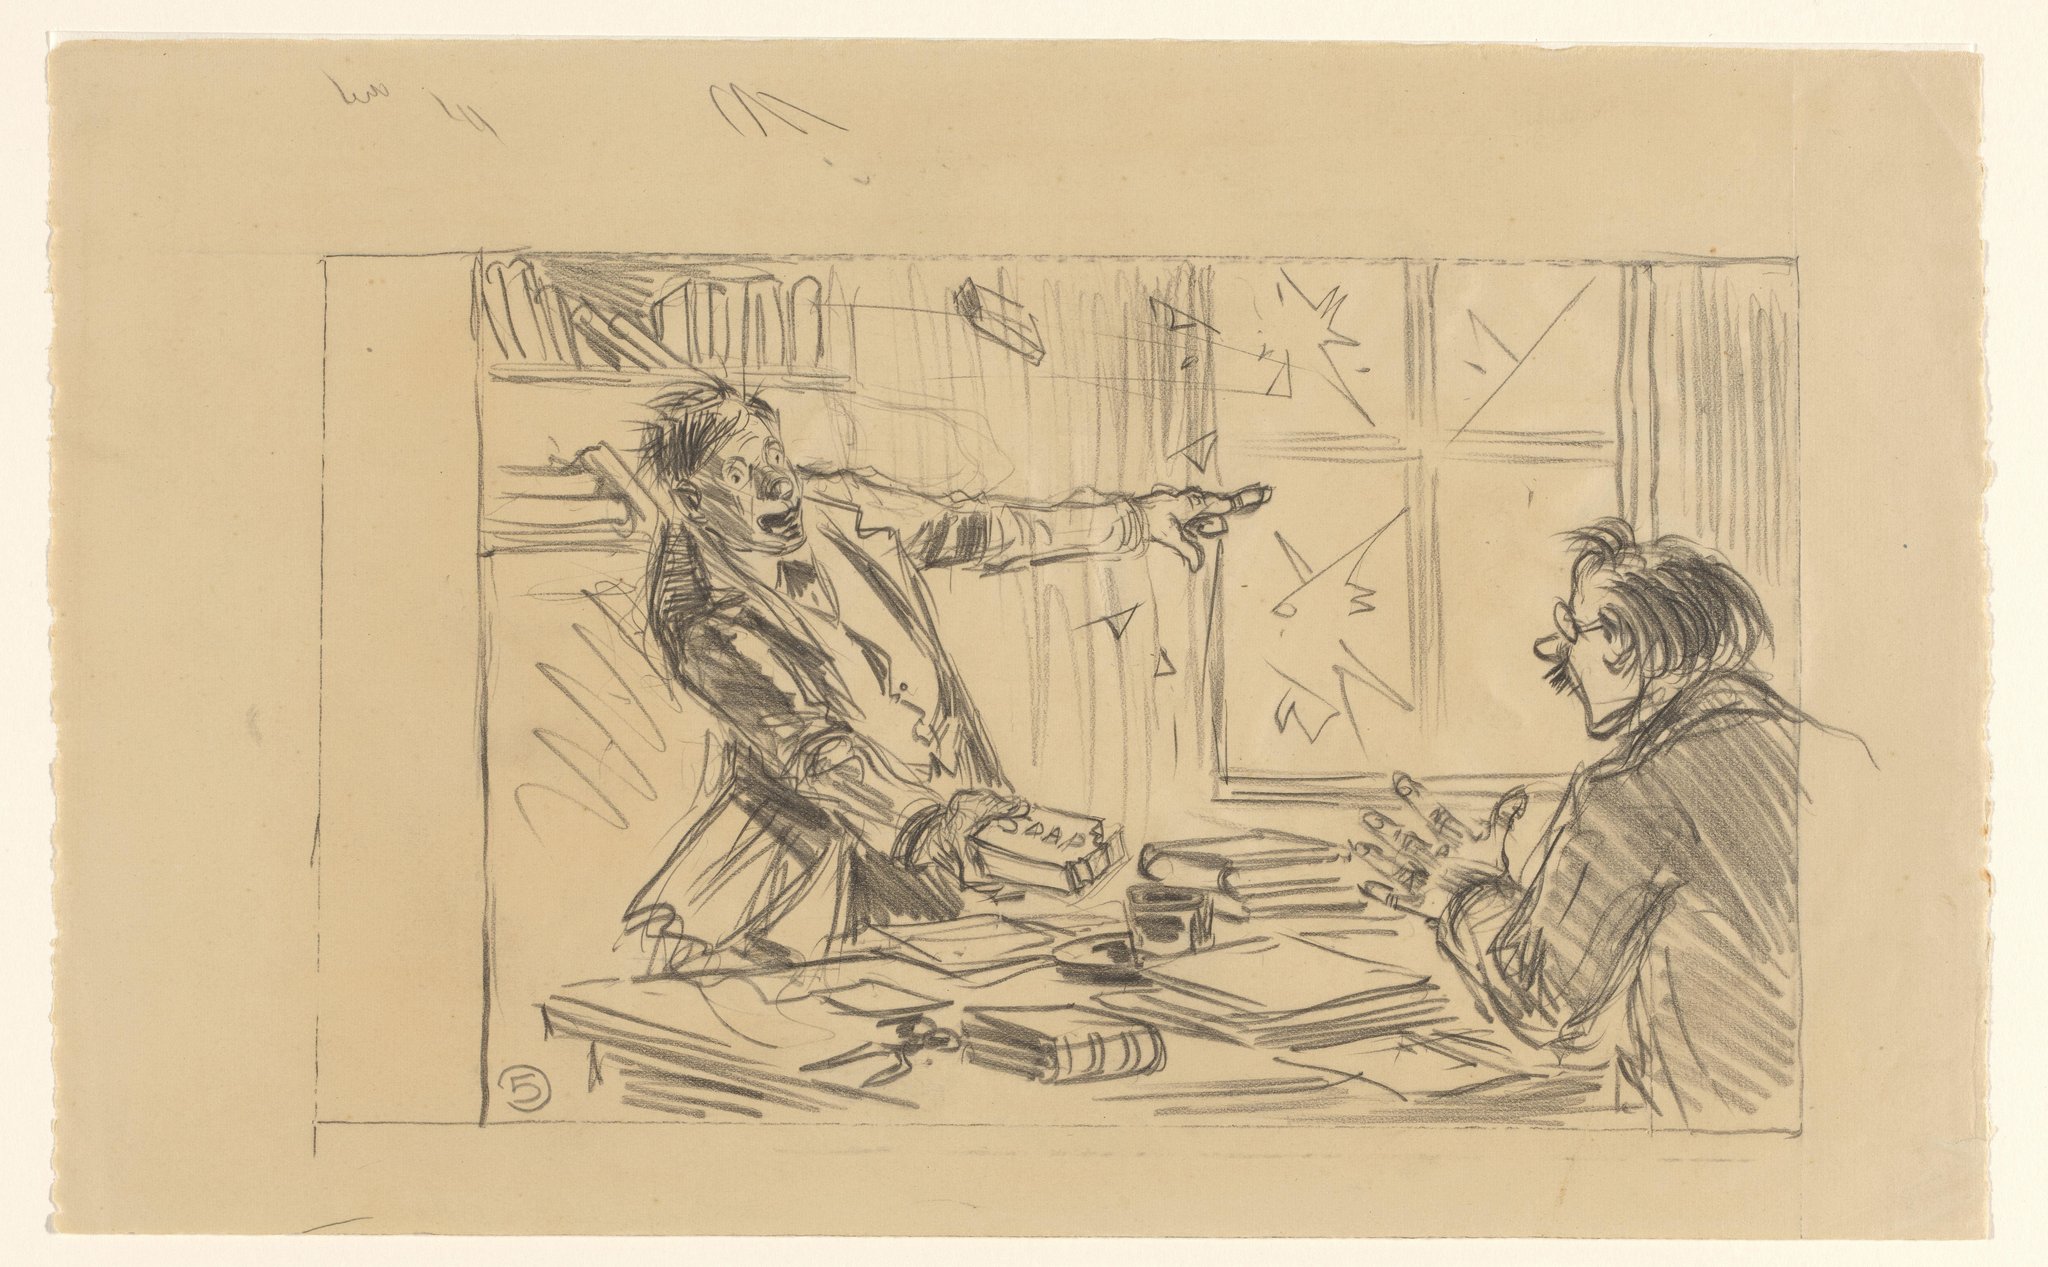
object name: drawing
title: Ontwerp voor een spotprent op de staking bij socialistisch dagblad Het Volk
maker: henricus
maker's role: draughtsman, print maker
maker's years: 1867-1921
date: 1906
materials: chalk, paper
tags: window, editorial board, political caricatures and satires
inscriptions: number: ‘5’, collector's mark: Lugt 2228a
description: Twee redacteuren in een kantoor van Het Volk dat bekogeld wordt met bakstenen. De ruit van het kantoor is gesneuveld en één van de redacteuren houdt een baksteen vast met daarop 'SDAP', de afkorting van de Sociaal-Democratische Arbeiderspartij.